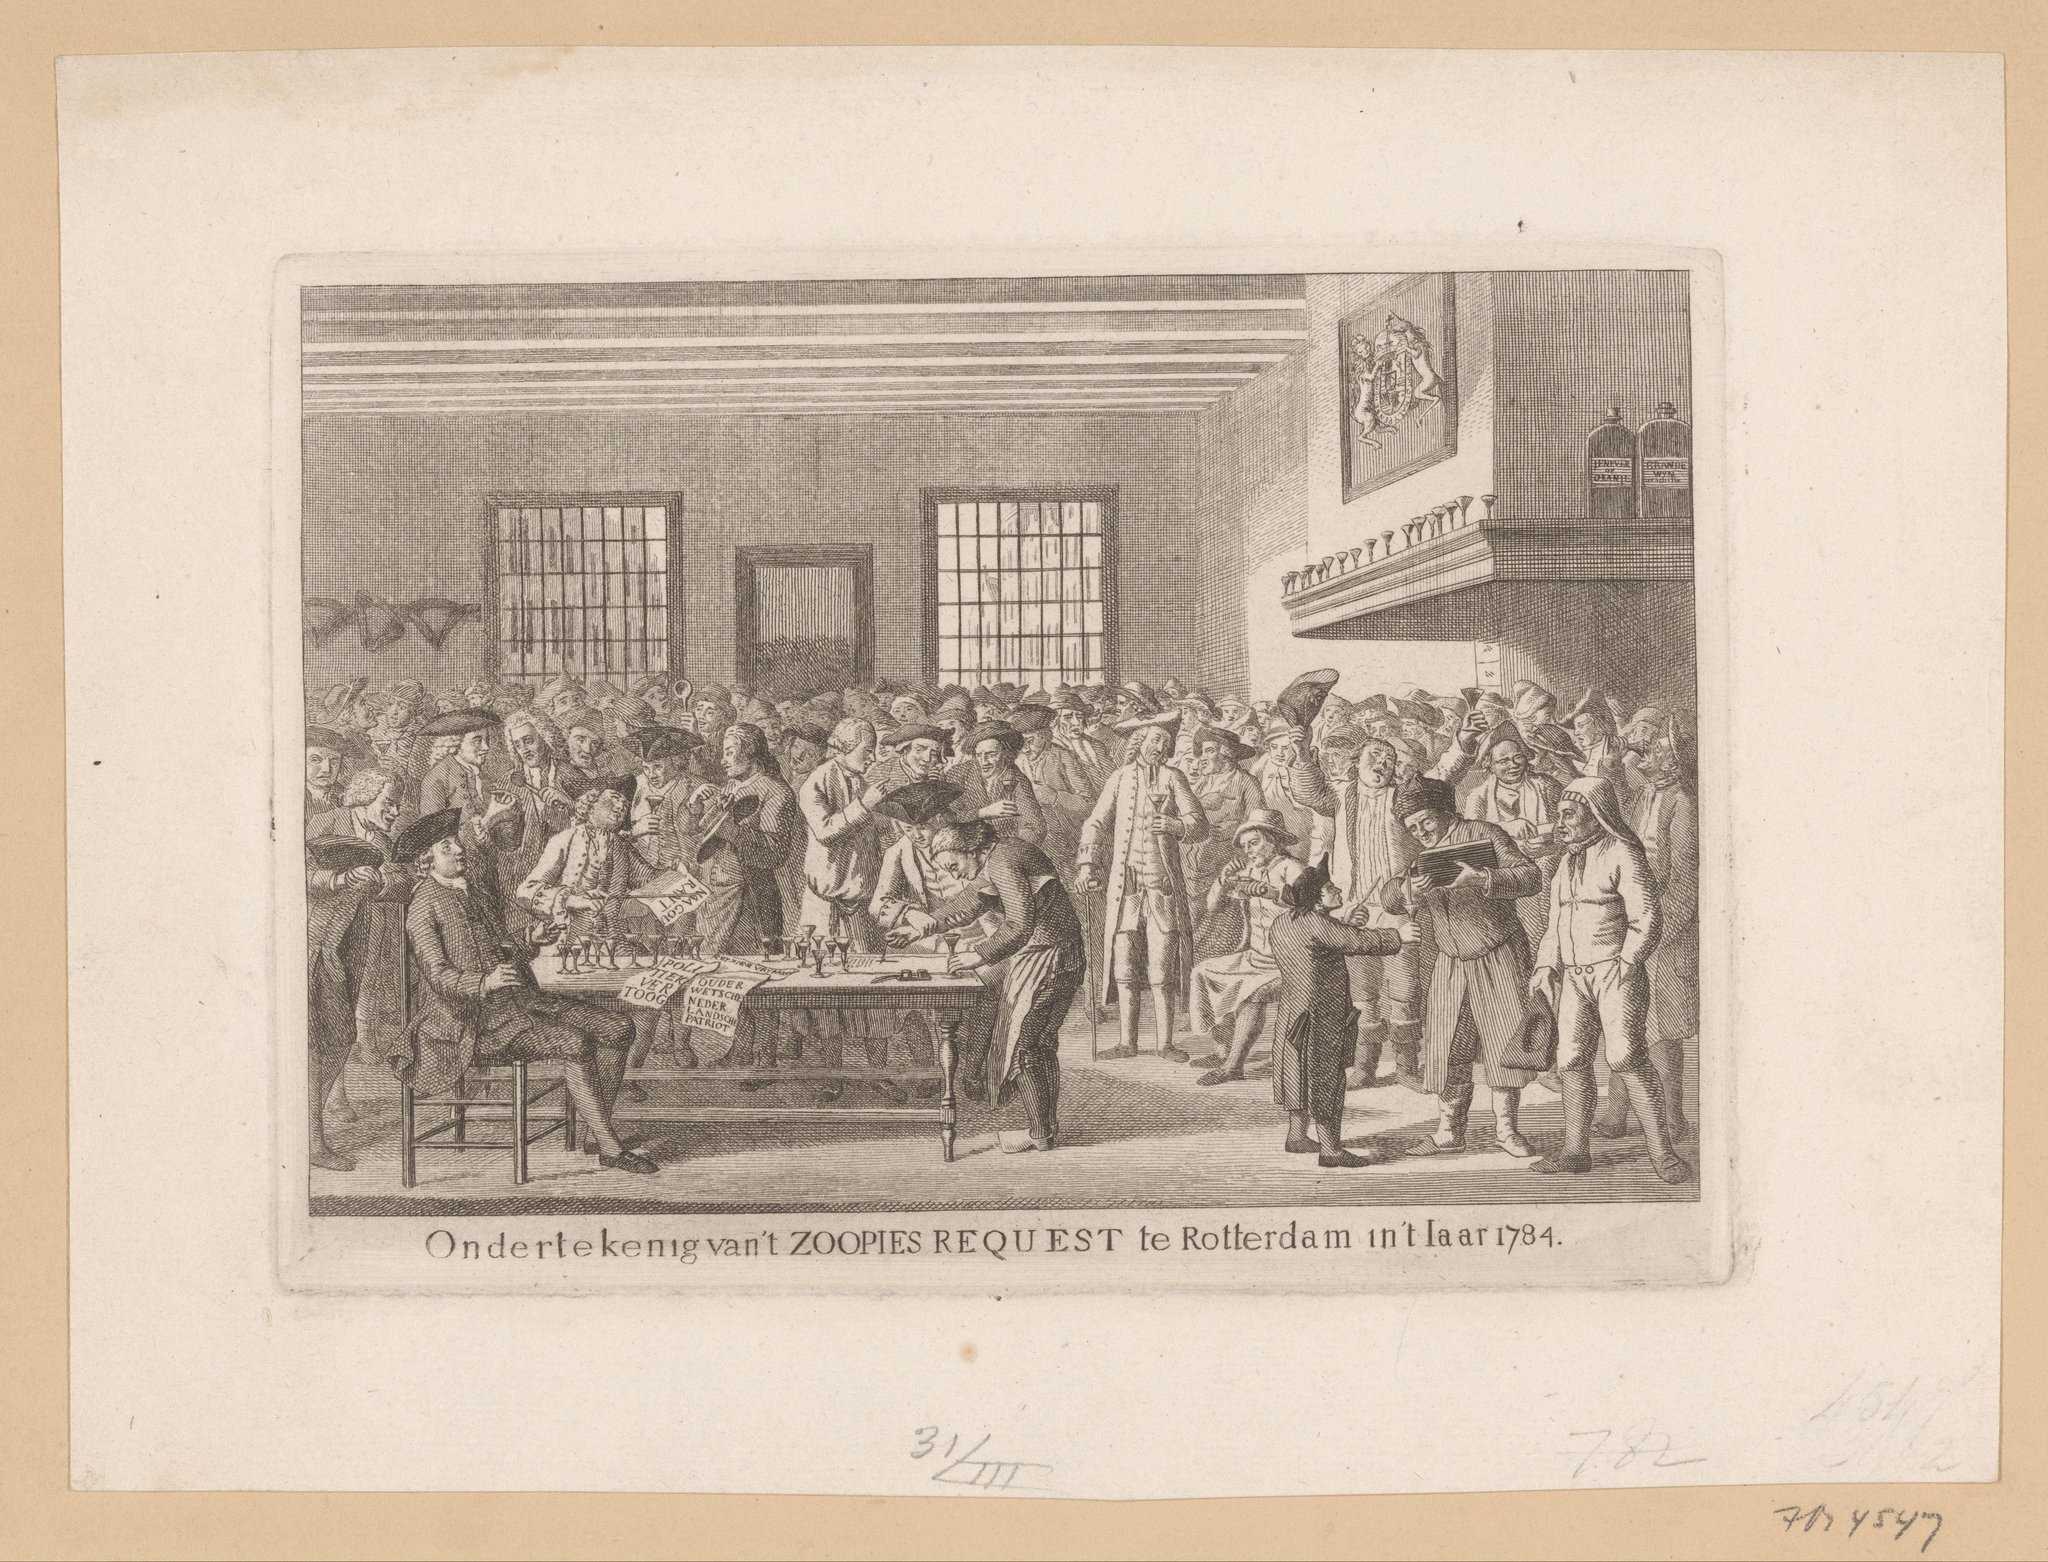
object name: print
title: Zoopies Request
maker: joannes hulstkamp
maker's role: print maker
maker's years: 1759-1786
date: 1784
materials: paper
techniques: engraving, etching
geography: rotterdam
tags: inn, coffee-house, public house, etc., rotterdam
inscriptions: date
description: De prent beeldt het verzamelen van handtekeningen af, voor het Orangistisch verzoek om de afschaffing van het in 1783 opgerichte Vrijkorps.